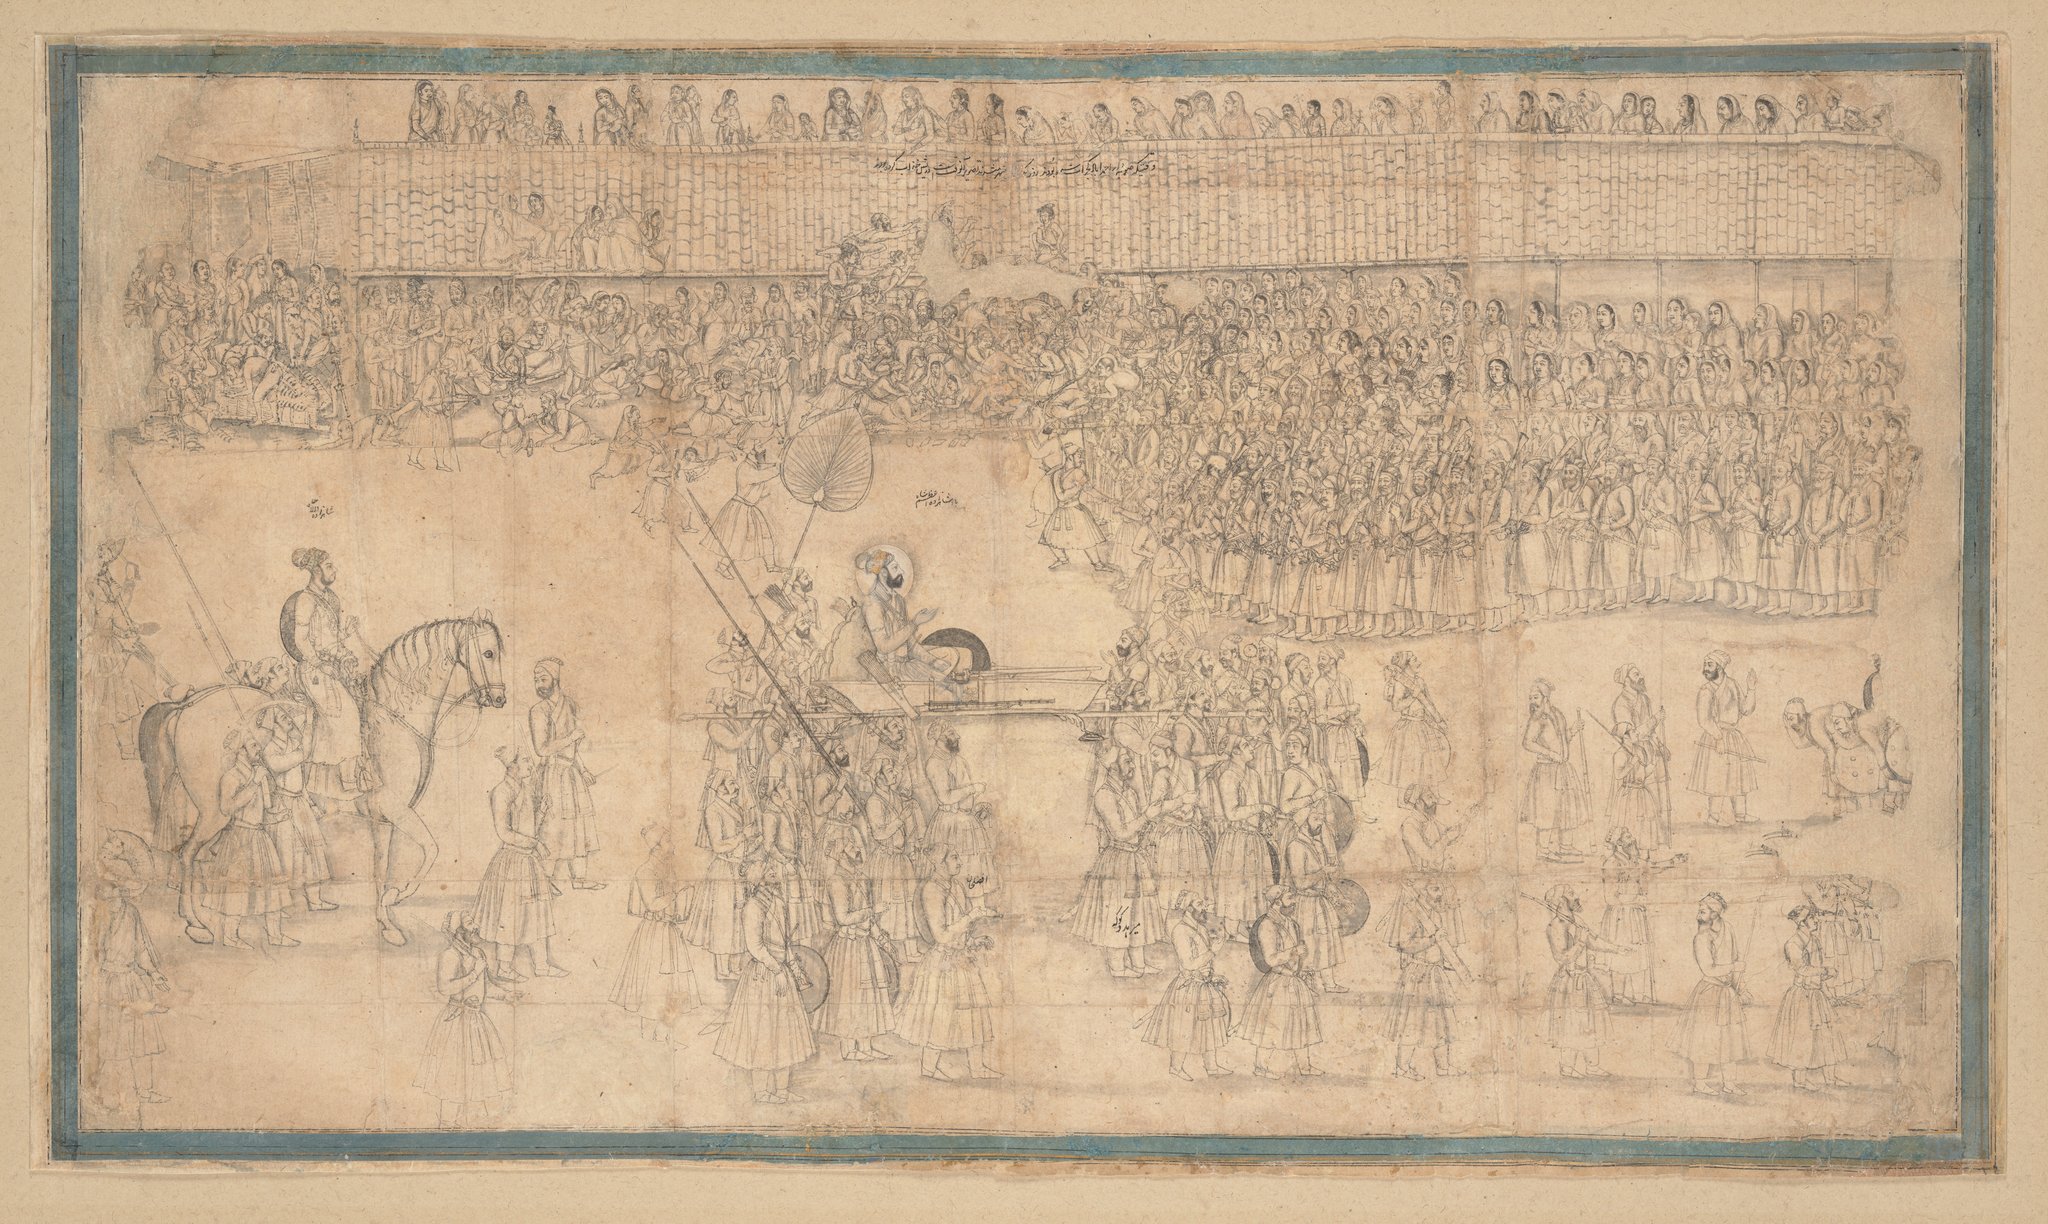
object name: illustrated single work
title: Prince A'zam Shah Enters Ahmedabad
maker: chitarman ii (kalyan das)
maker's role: artist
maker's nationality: indian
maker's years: 1690-1755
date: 1701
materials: gold, paper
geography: india